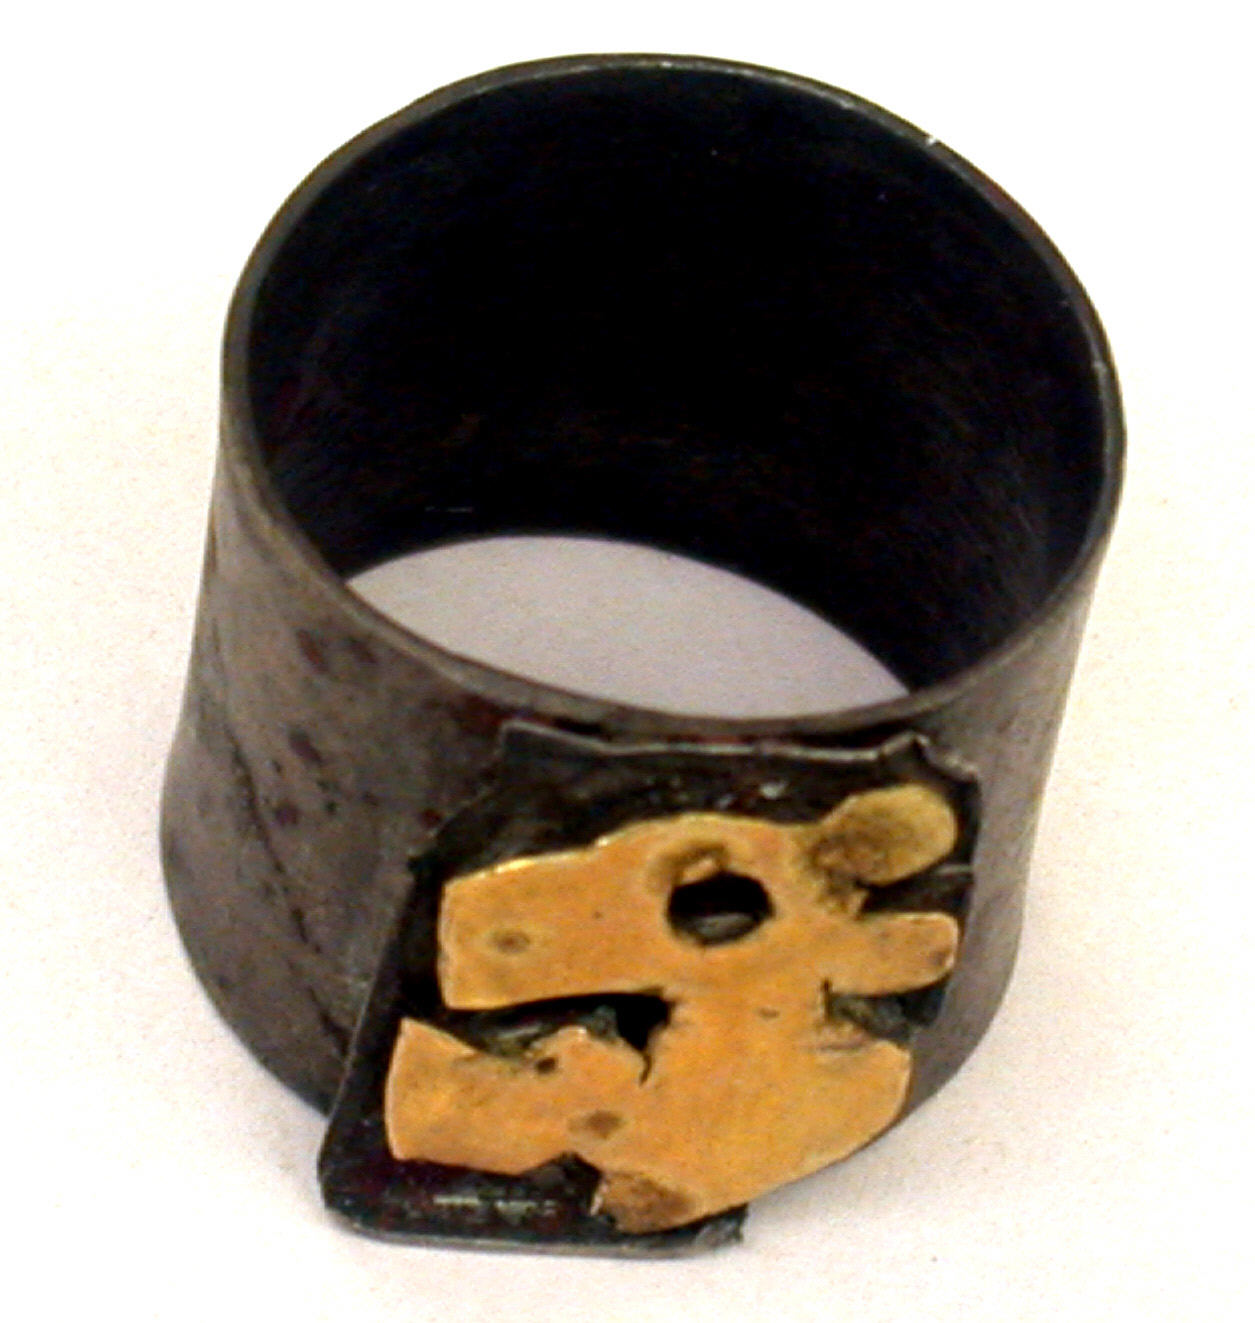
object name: ring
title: Silver Ring with Gold Animal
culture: peruvian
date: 1501-1600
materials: gold, silver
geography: peru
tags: animals